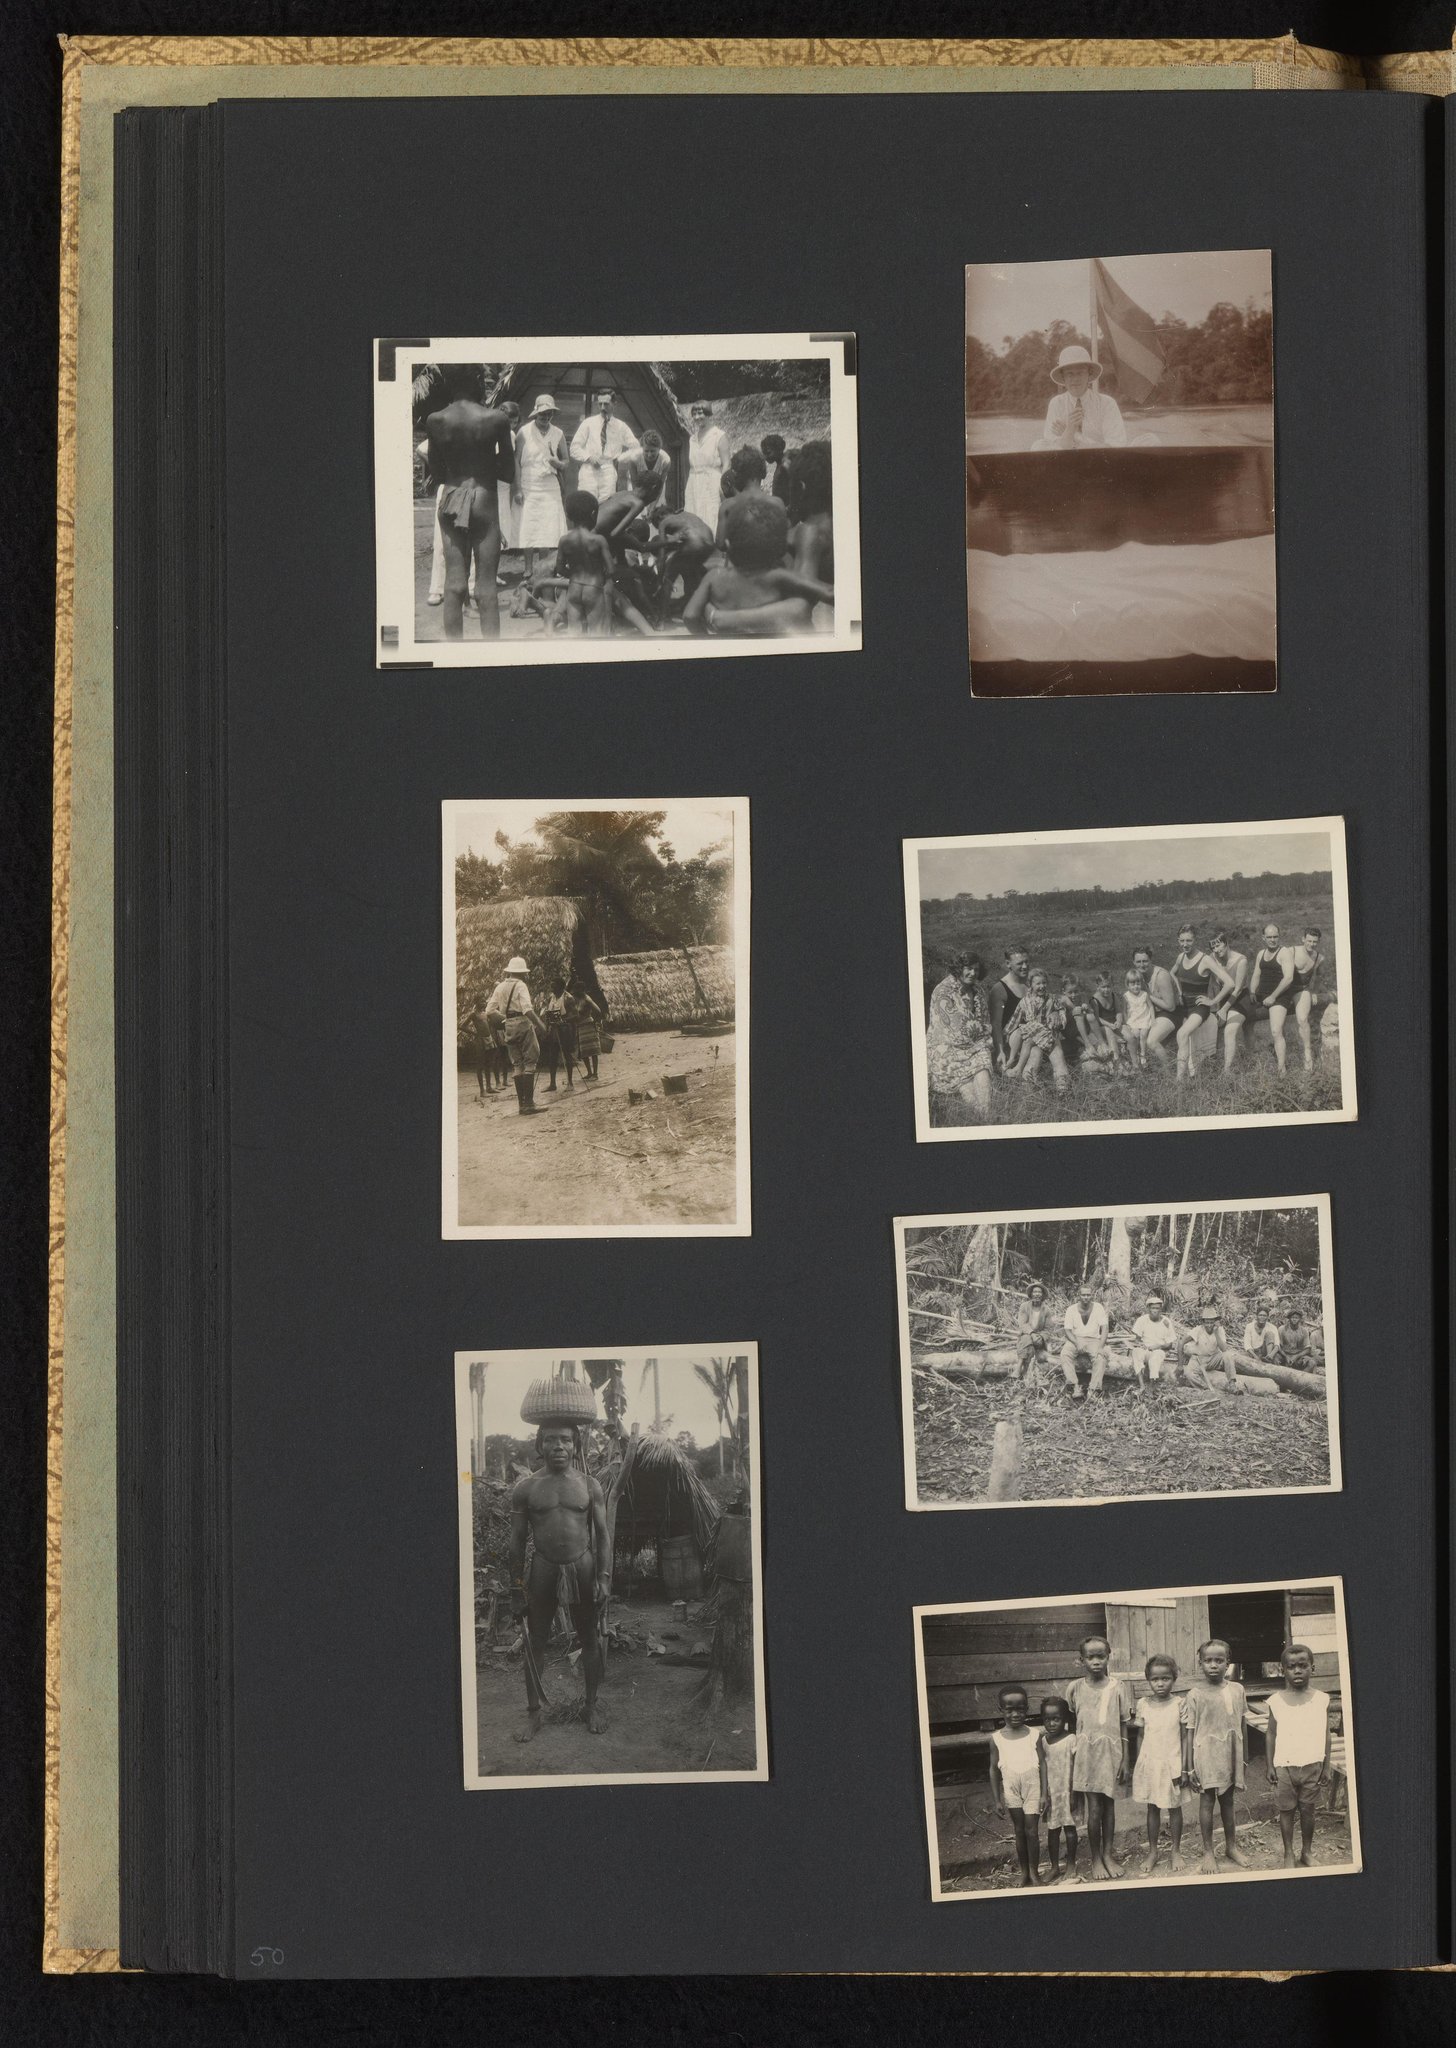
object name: album leaf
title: Bezoek aan een dorp en zwempartij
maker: Anonymous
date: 1927-1931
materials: paper, photographic support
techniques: gelatin silver print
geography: suriname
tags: village, swimming (sport), suriname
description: Albumblad met zeven foto's van een bezoek gebracht door een groep Europeanen aan een Surinaams dorp en van een zwempartij. Onderdeel van het album van de familie Guilonard over de bauxietwinning in Moengo en Albina in Suriname in de jaren 1929-1930.